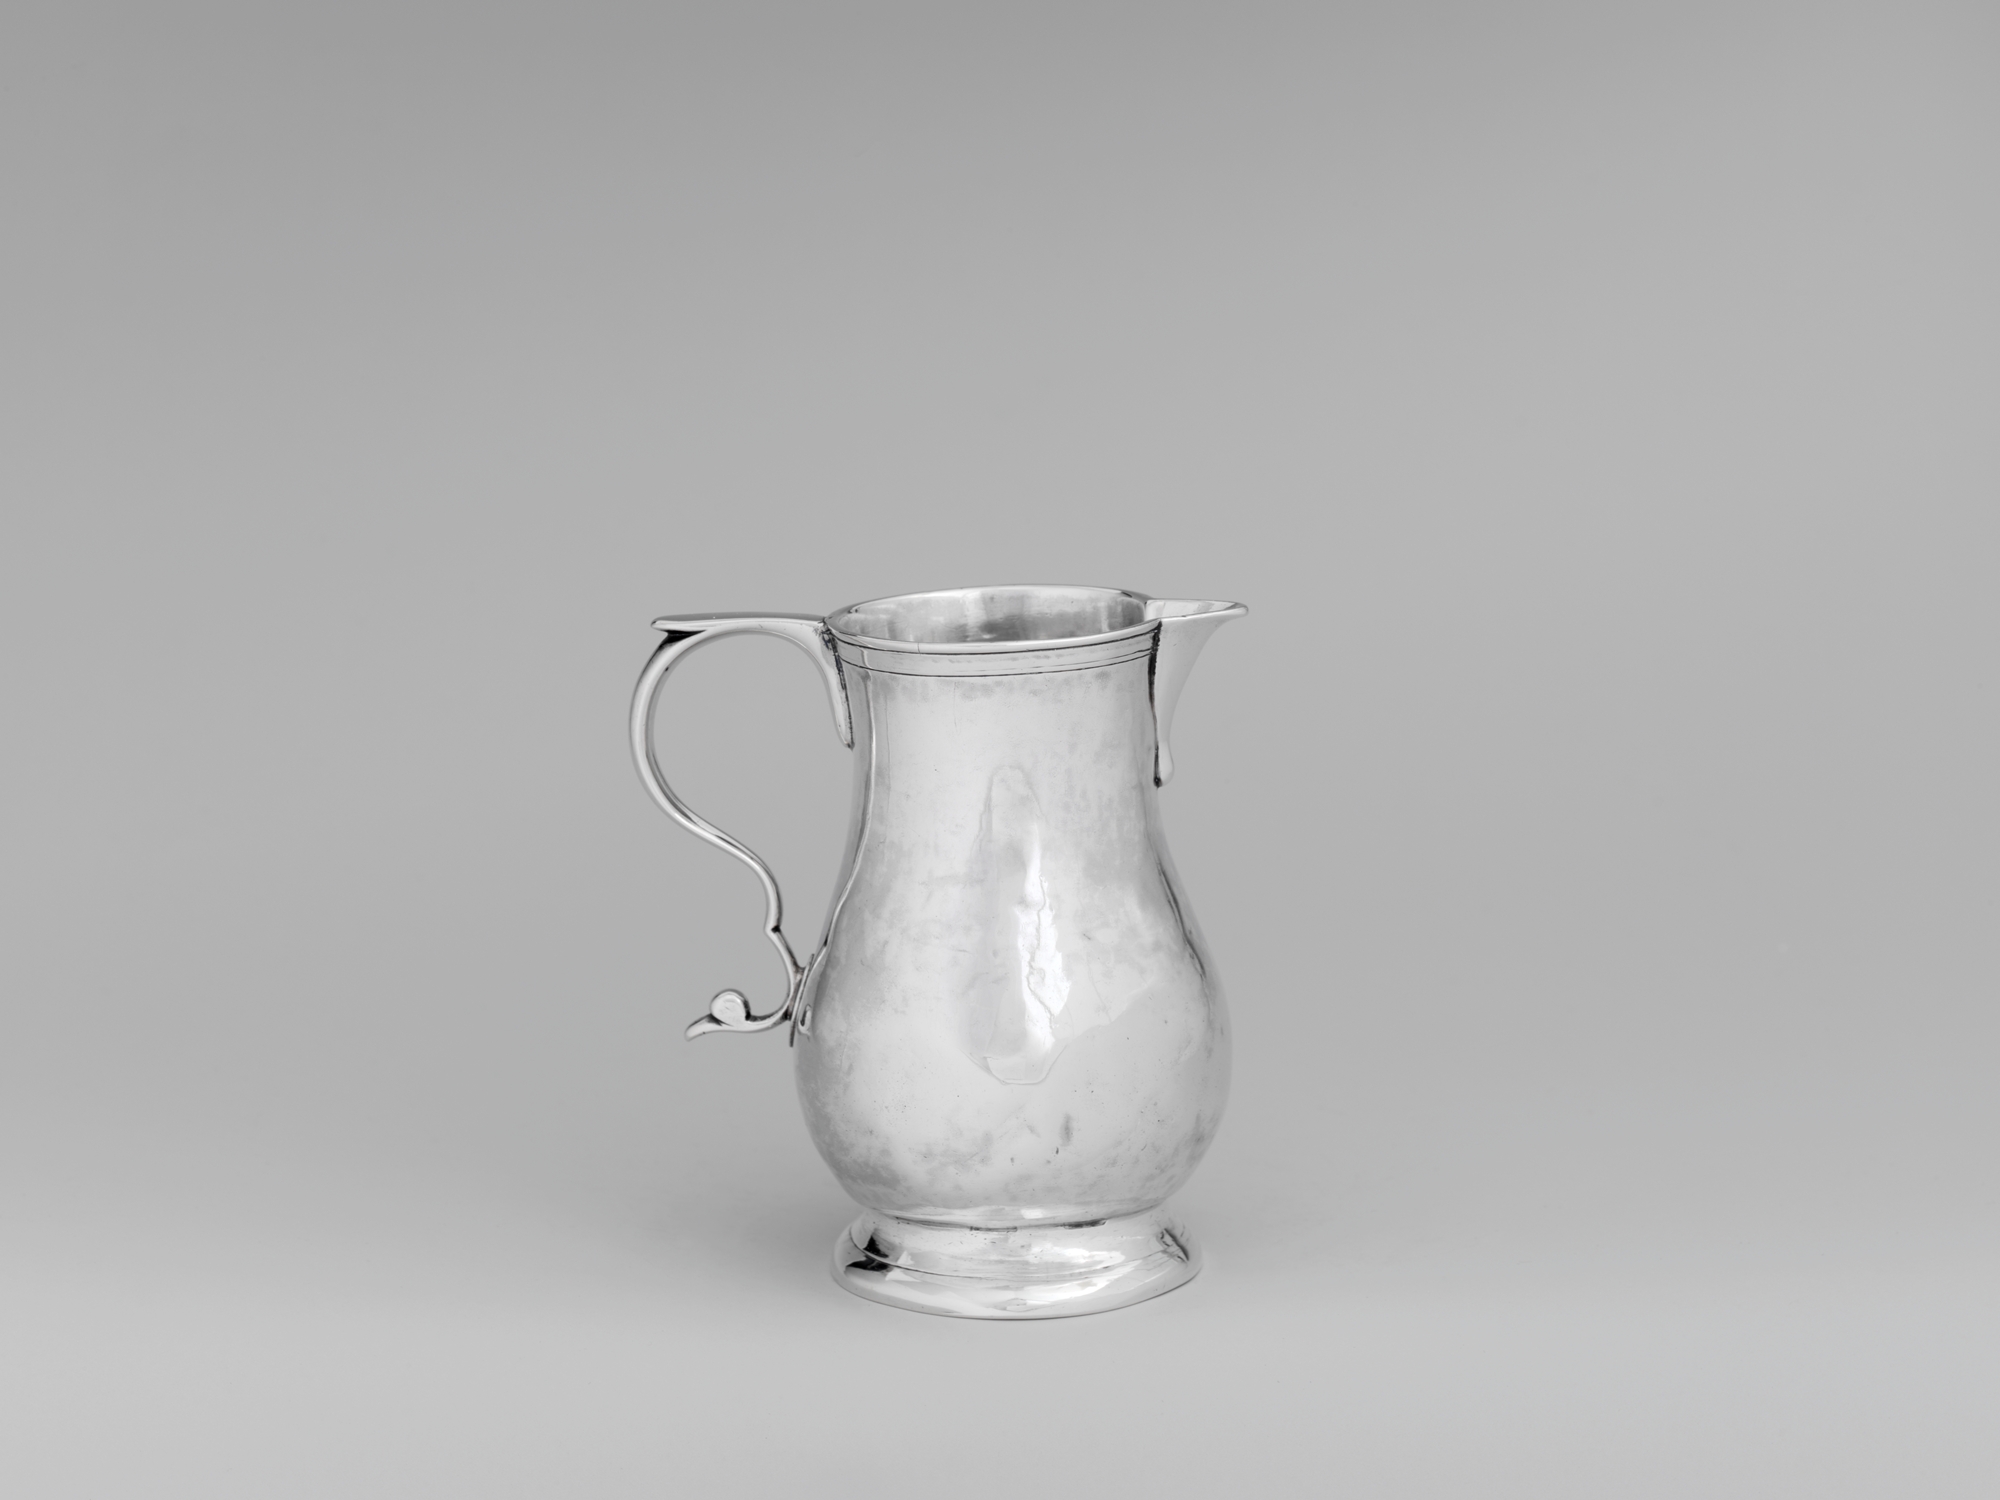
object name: cream pot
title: Creampot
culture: american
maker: jacob hurd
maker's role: maker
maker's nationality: american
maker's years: 1702-1758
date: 1735-1745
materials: silver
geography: united states